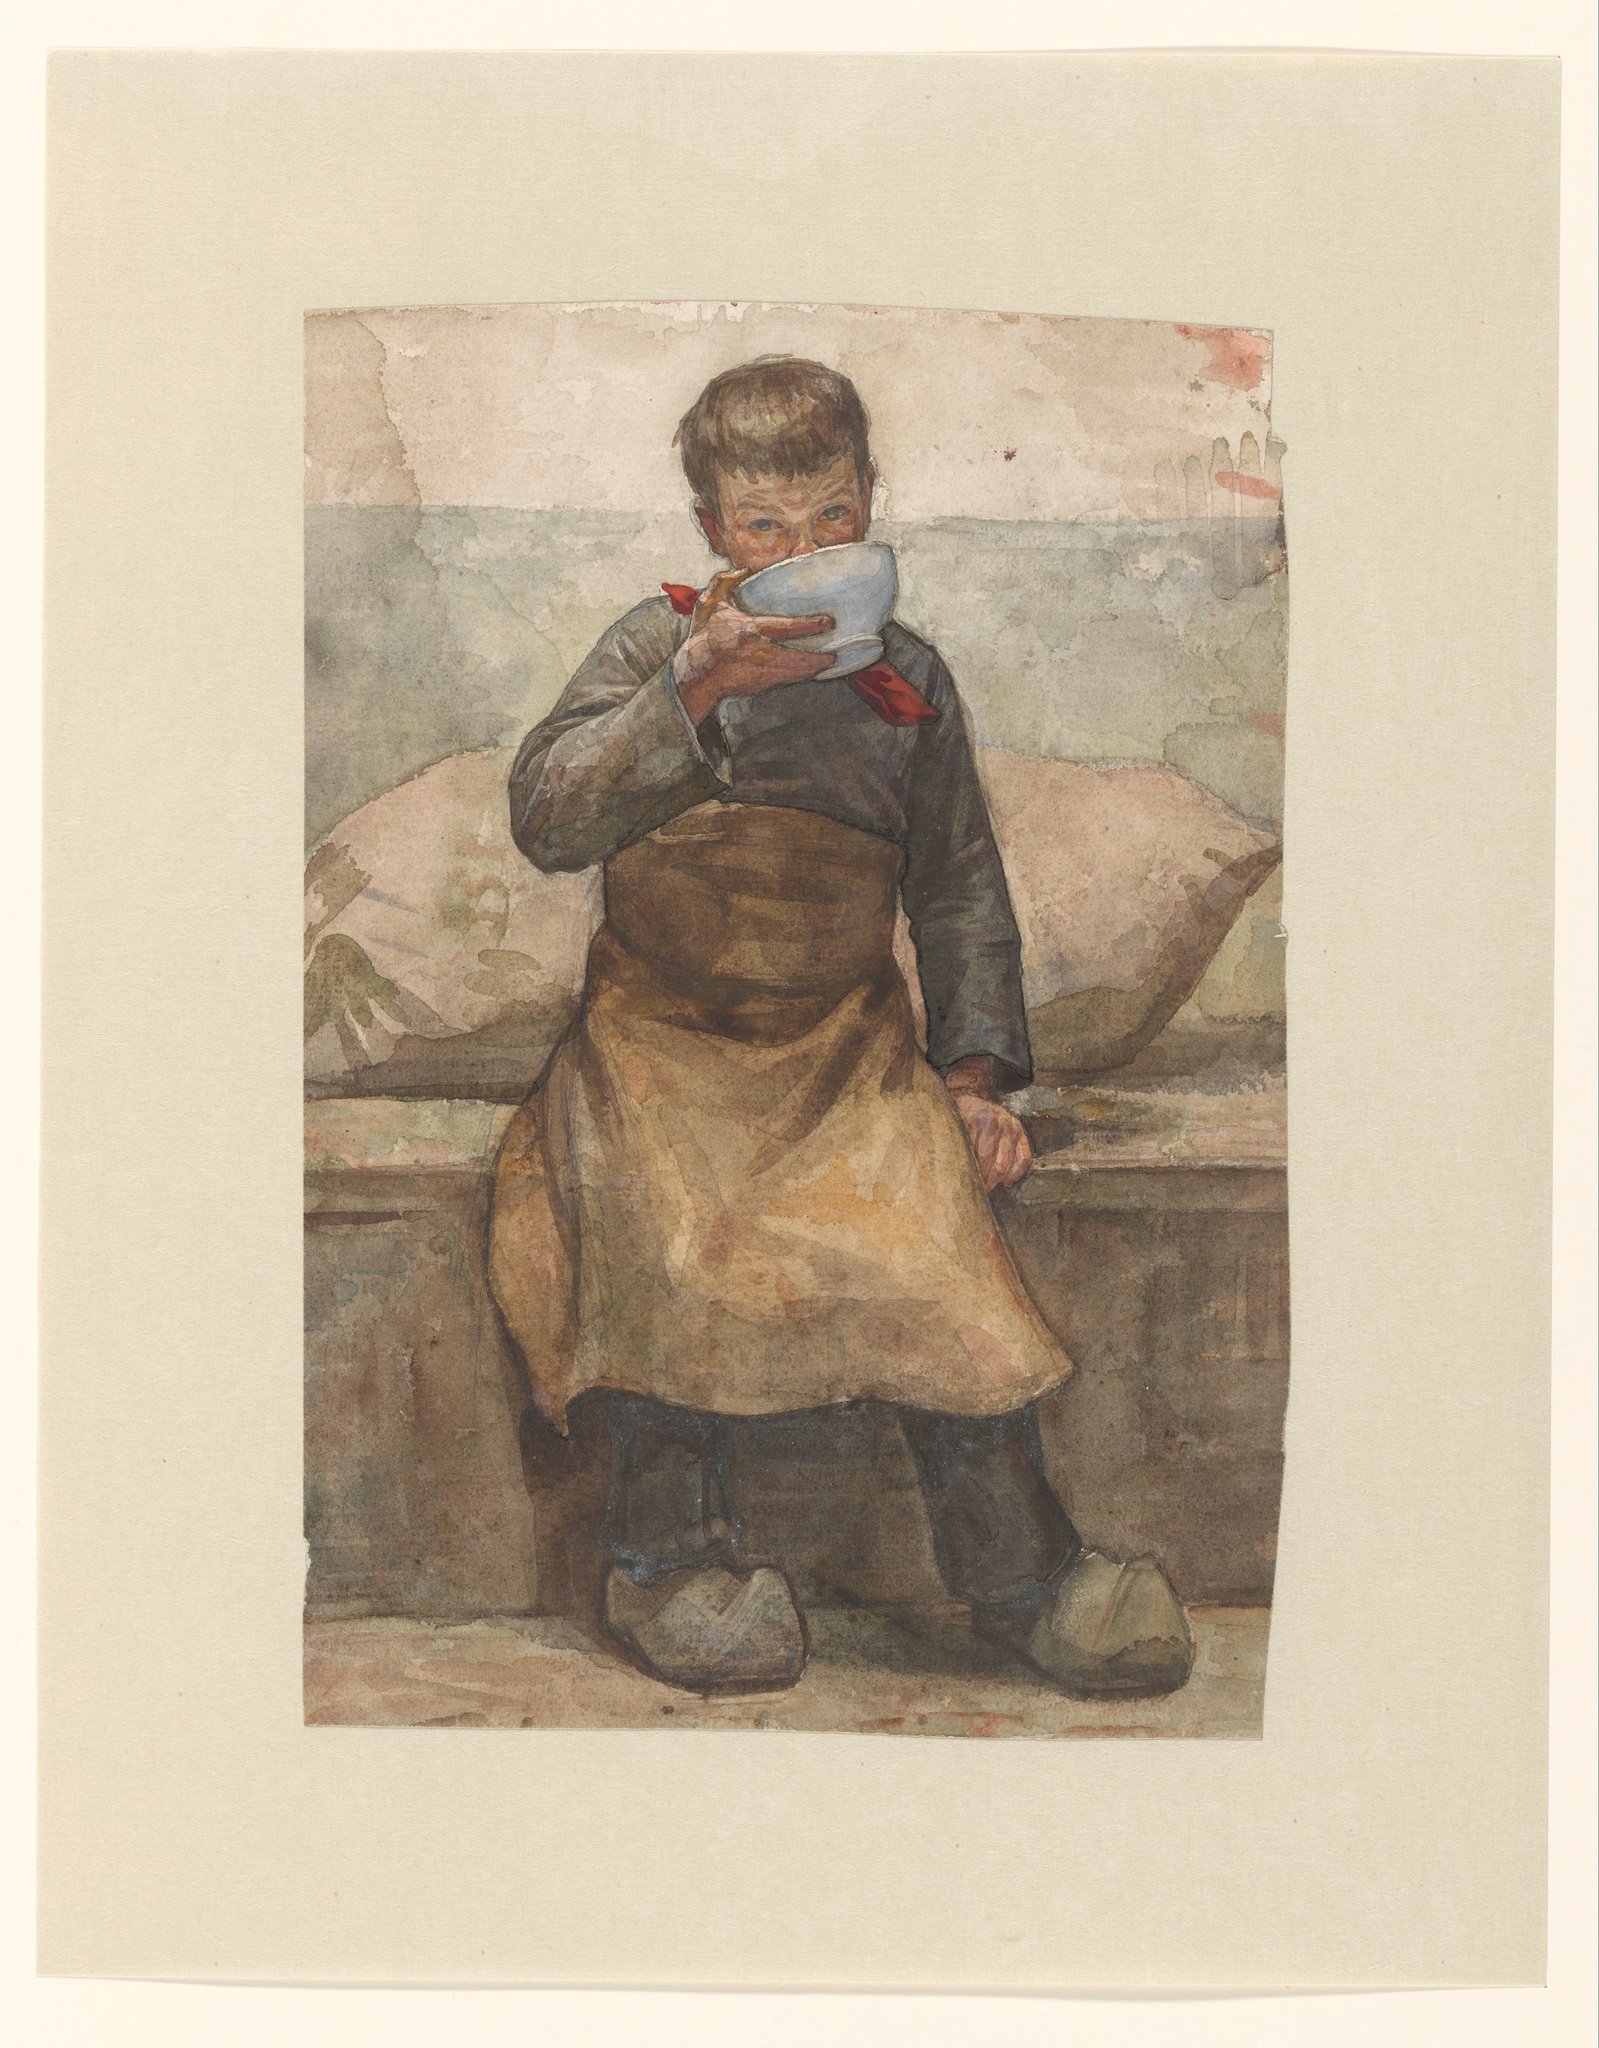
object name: drawing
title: Drinkende jongen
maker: jan veth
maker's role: designer, draughtsman, painter, print maker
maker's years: 1864-1925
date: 1874-1925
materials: paper, pencil, watercolor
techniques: brush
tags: anonymous historical person portrayed alone